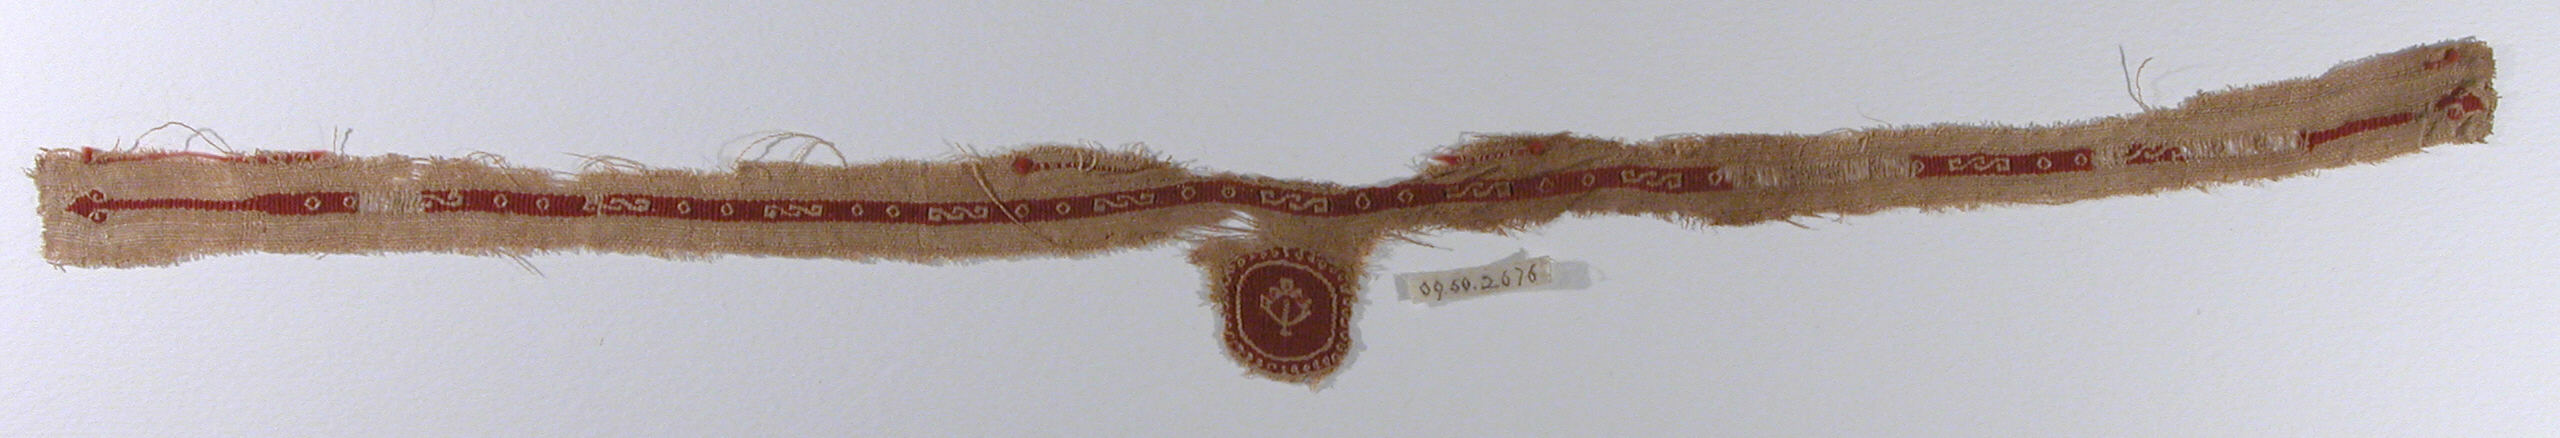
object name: shoulder band fragment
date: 401-500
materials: linen, wool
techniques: weave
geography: egypt